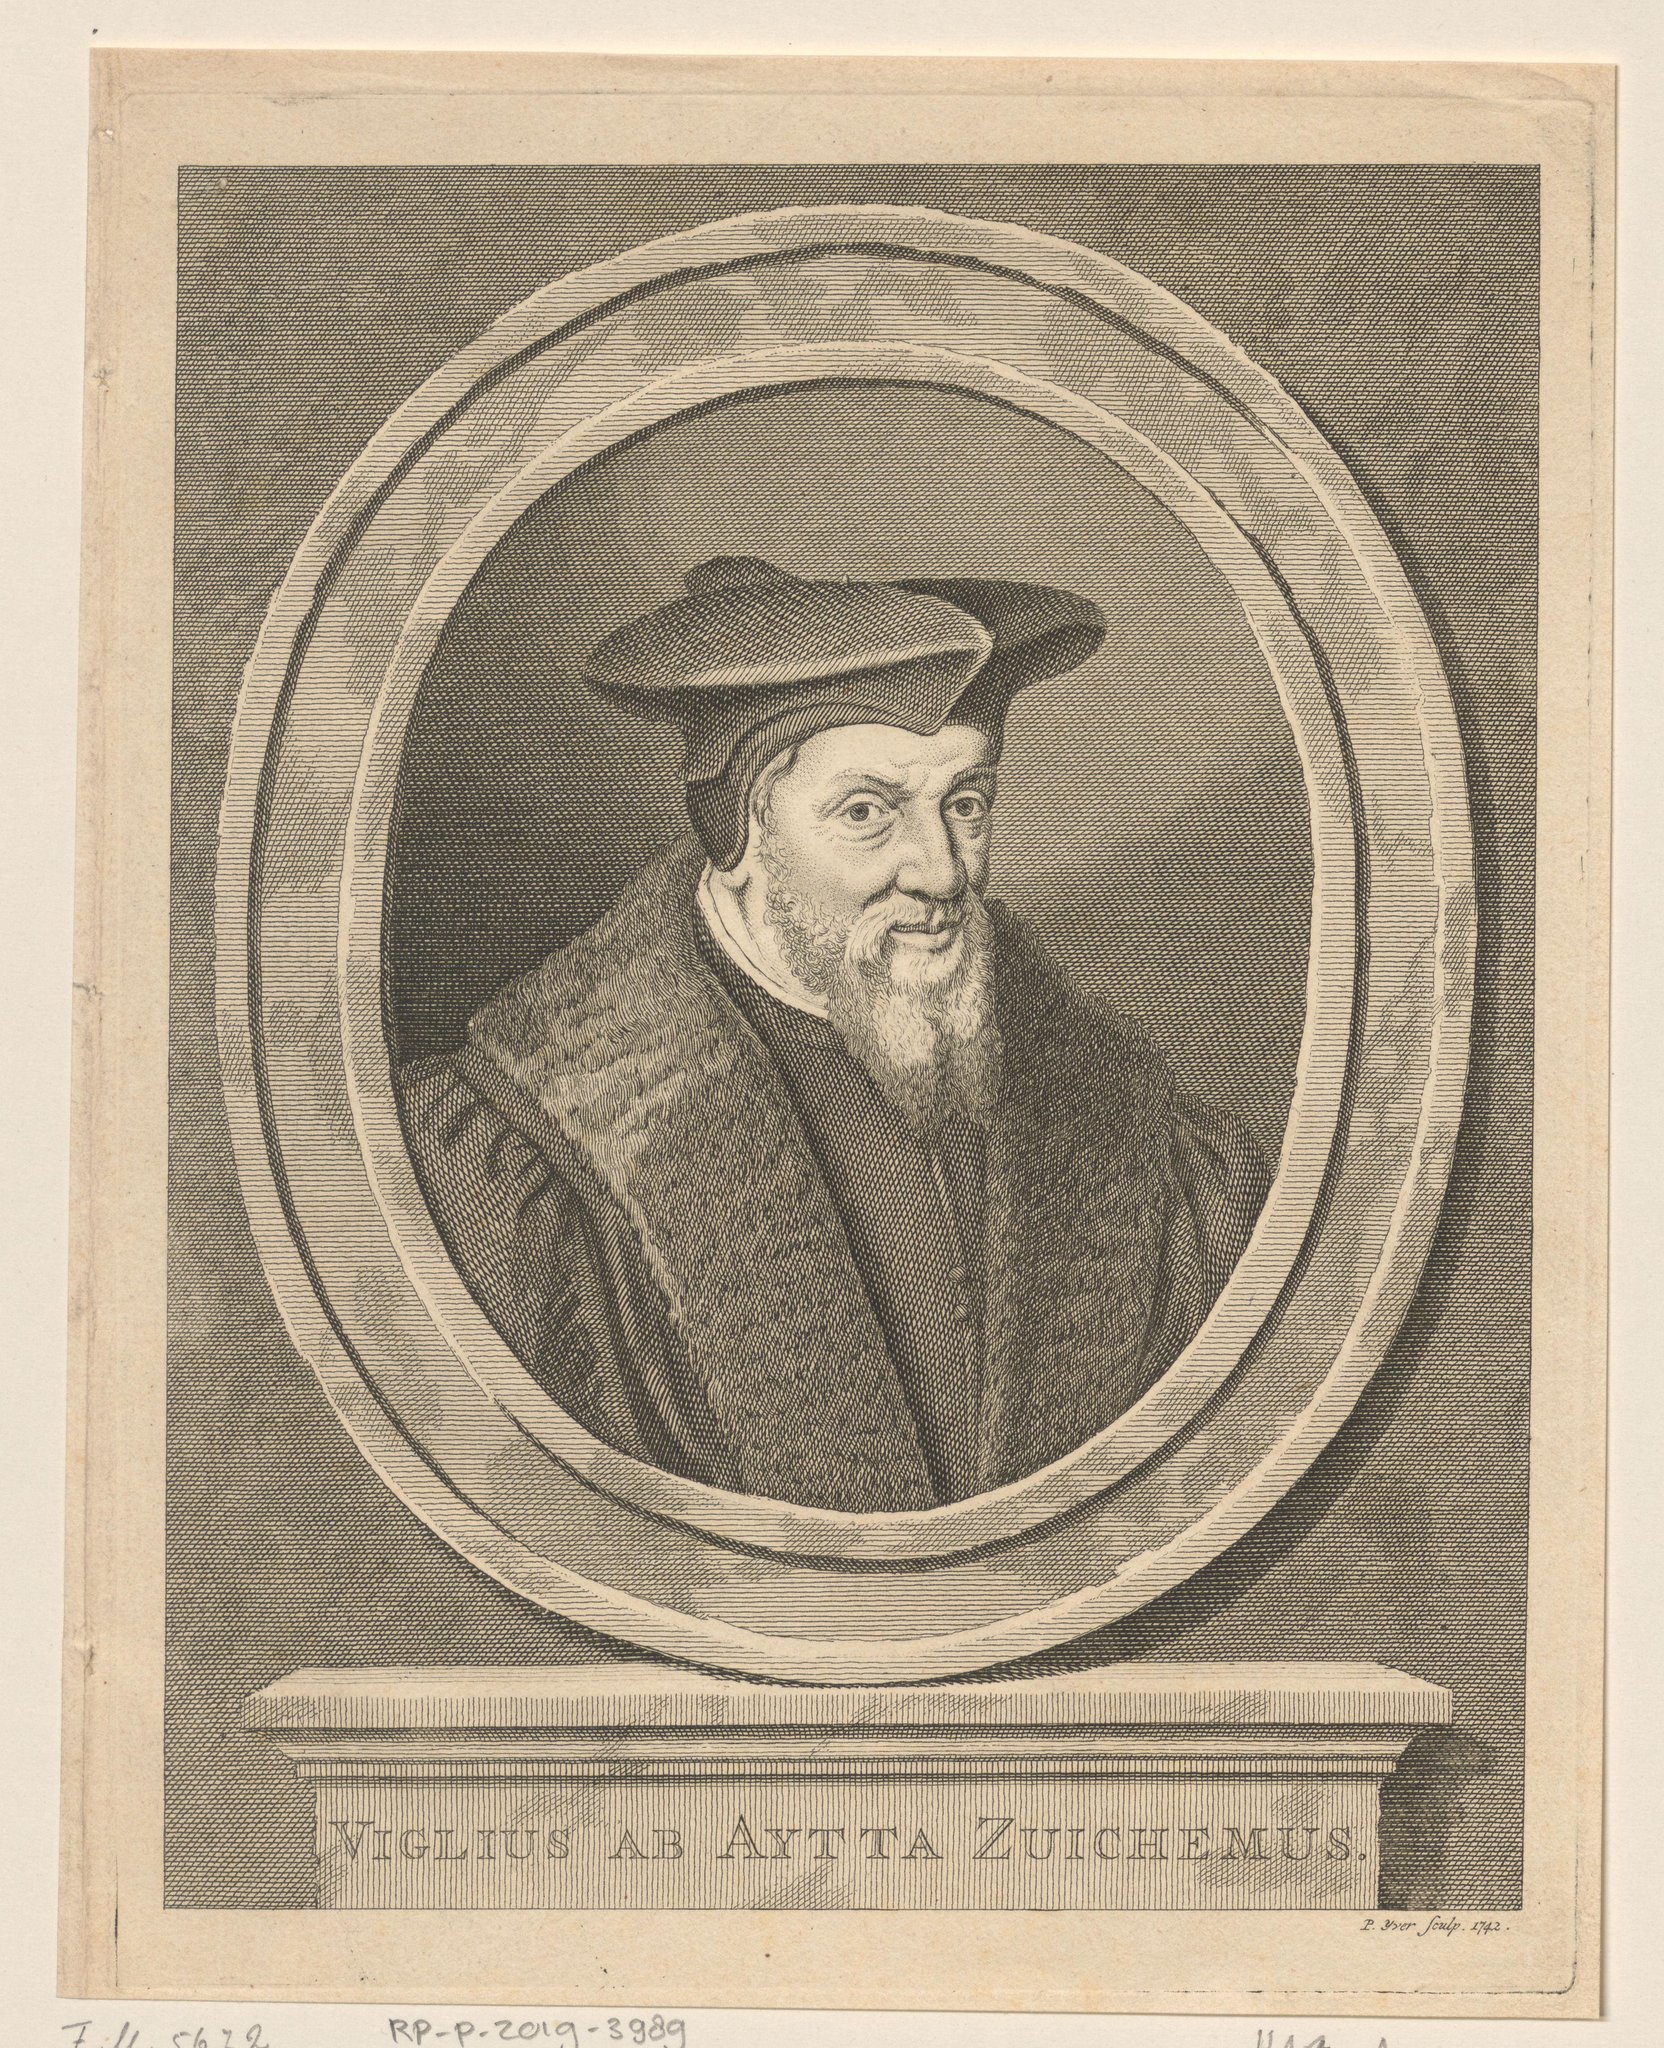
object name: print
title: Portret van Viglius ab Aytta Zuichemus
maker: pieter yver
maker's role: print maker, publisher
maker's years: 1712-1787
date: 1742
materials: paper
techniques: engraving, etching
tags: brussels, clergyman, historical persons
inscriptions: date